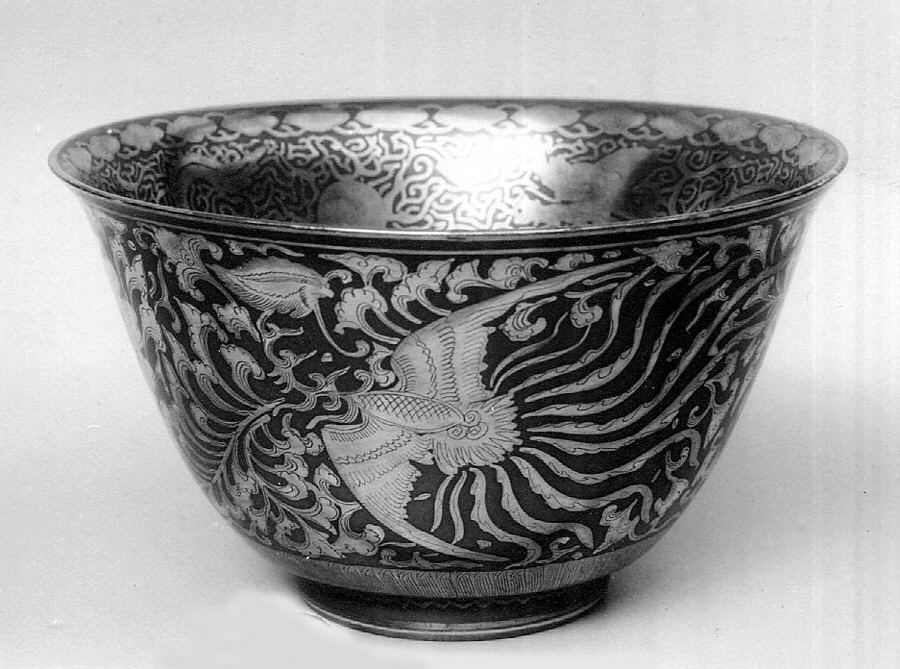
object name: bowl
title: Bowl with Phoenixes and Auspicious Motifs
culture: japanese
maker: eiraku tokuzen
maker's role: artist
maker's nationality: japanese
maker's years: 1853-1909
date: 1851-1900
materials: cobalt, glaze, gold, porcelain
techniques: painting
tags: phoenix